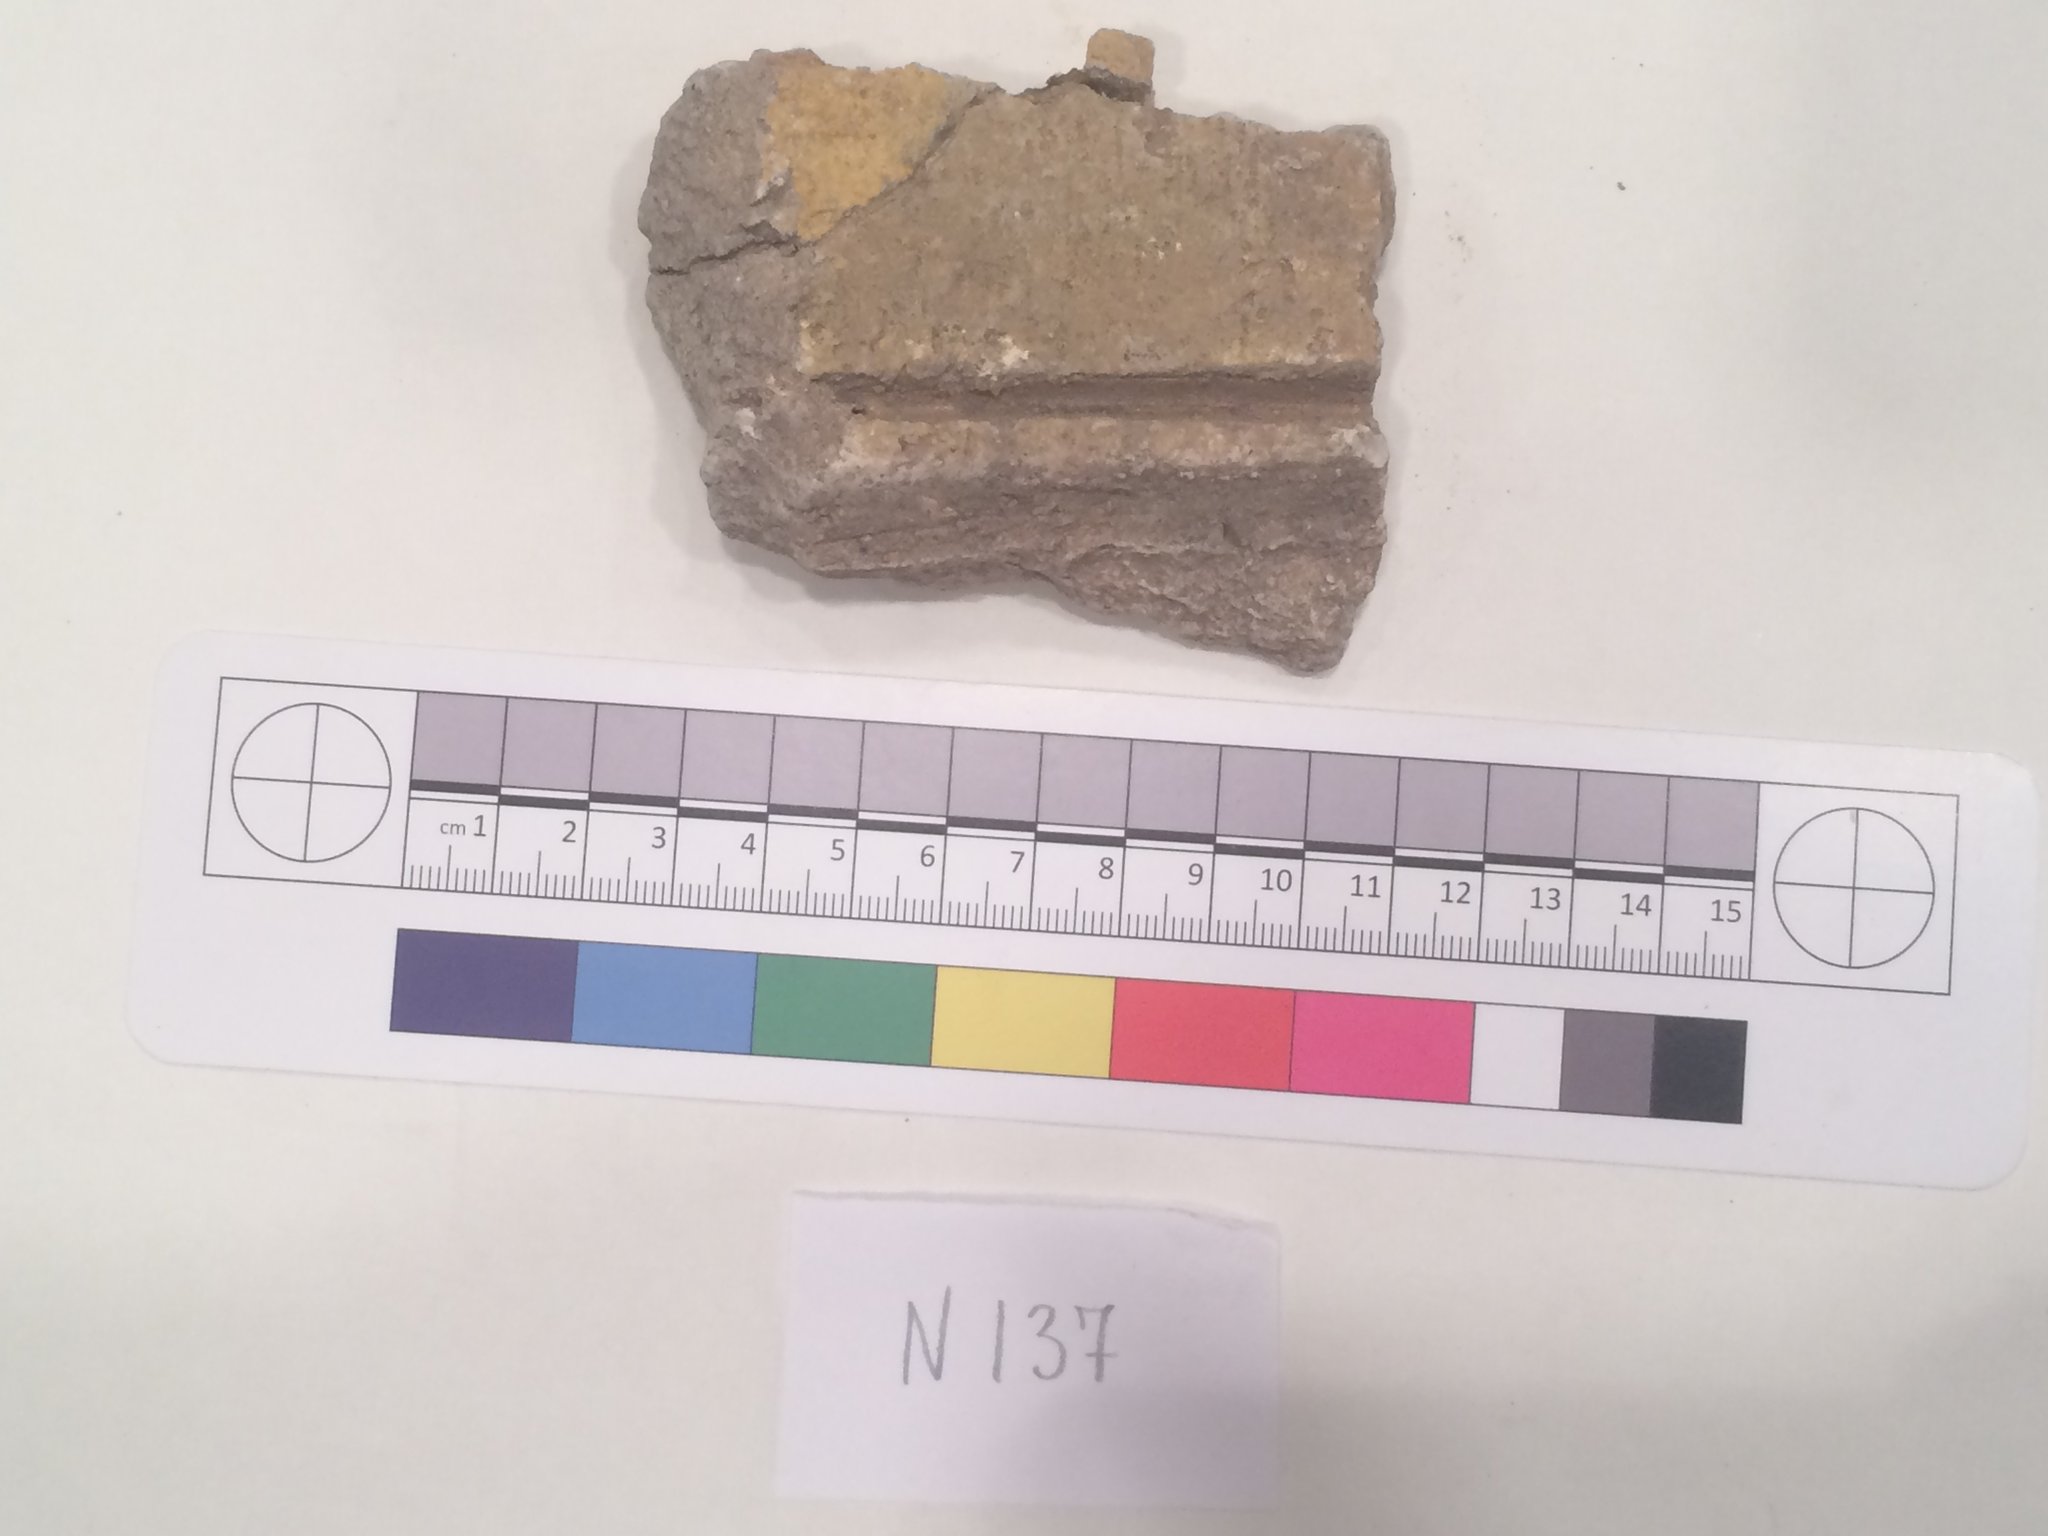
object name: fragment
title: Stucco Fragment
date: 701-1200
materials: plaster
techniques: carving, painting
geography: iran